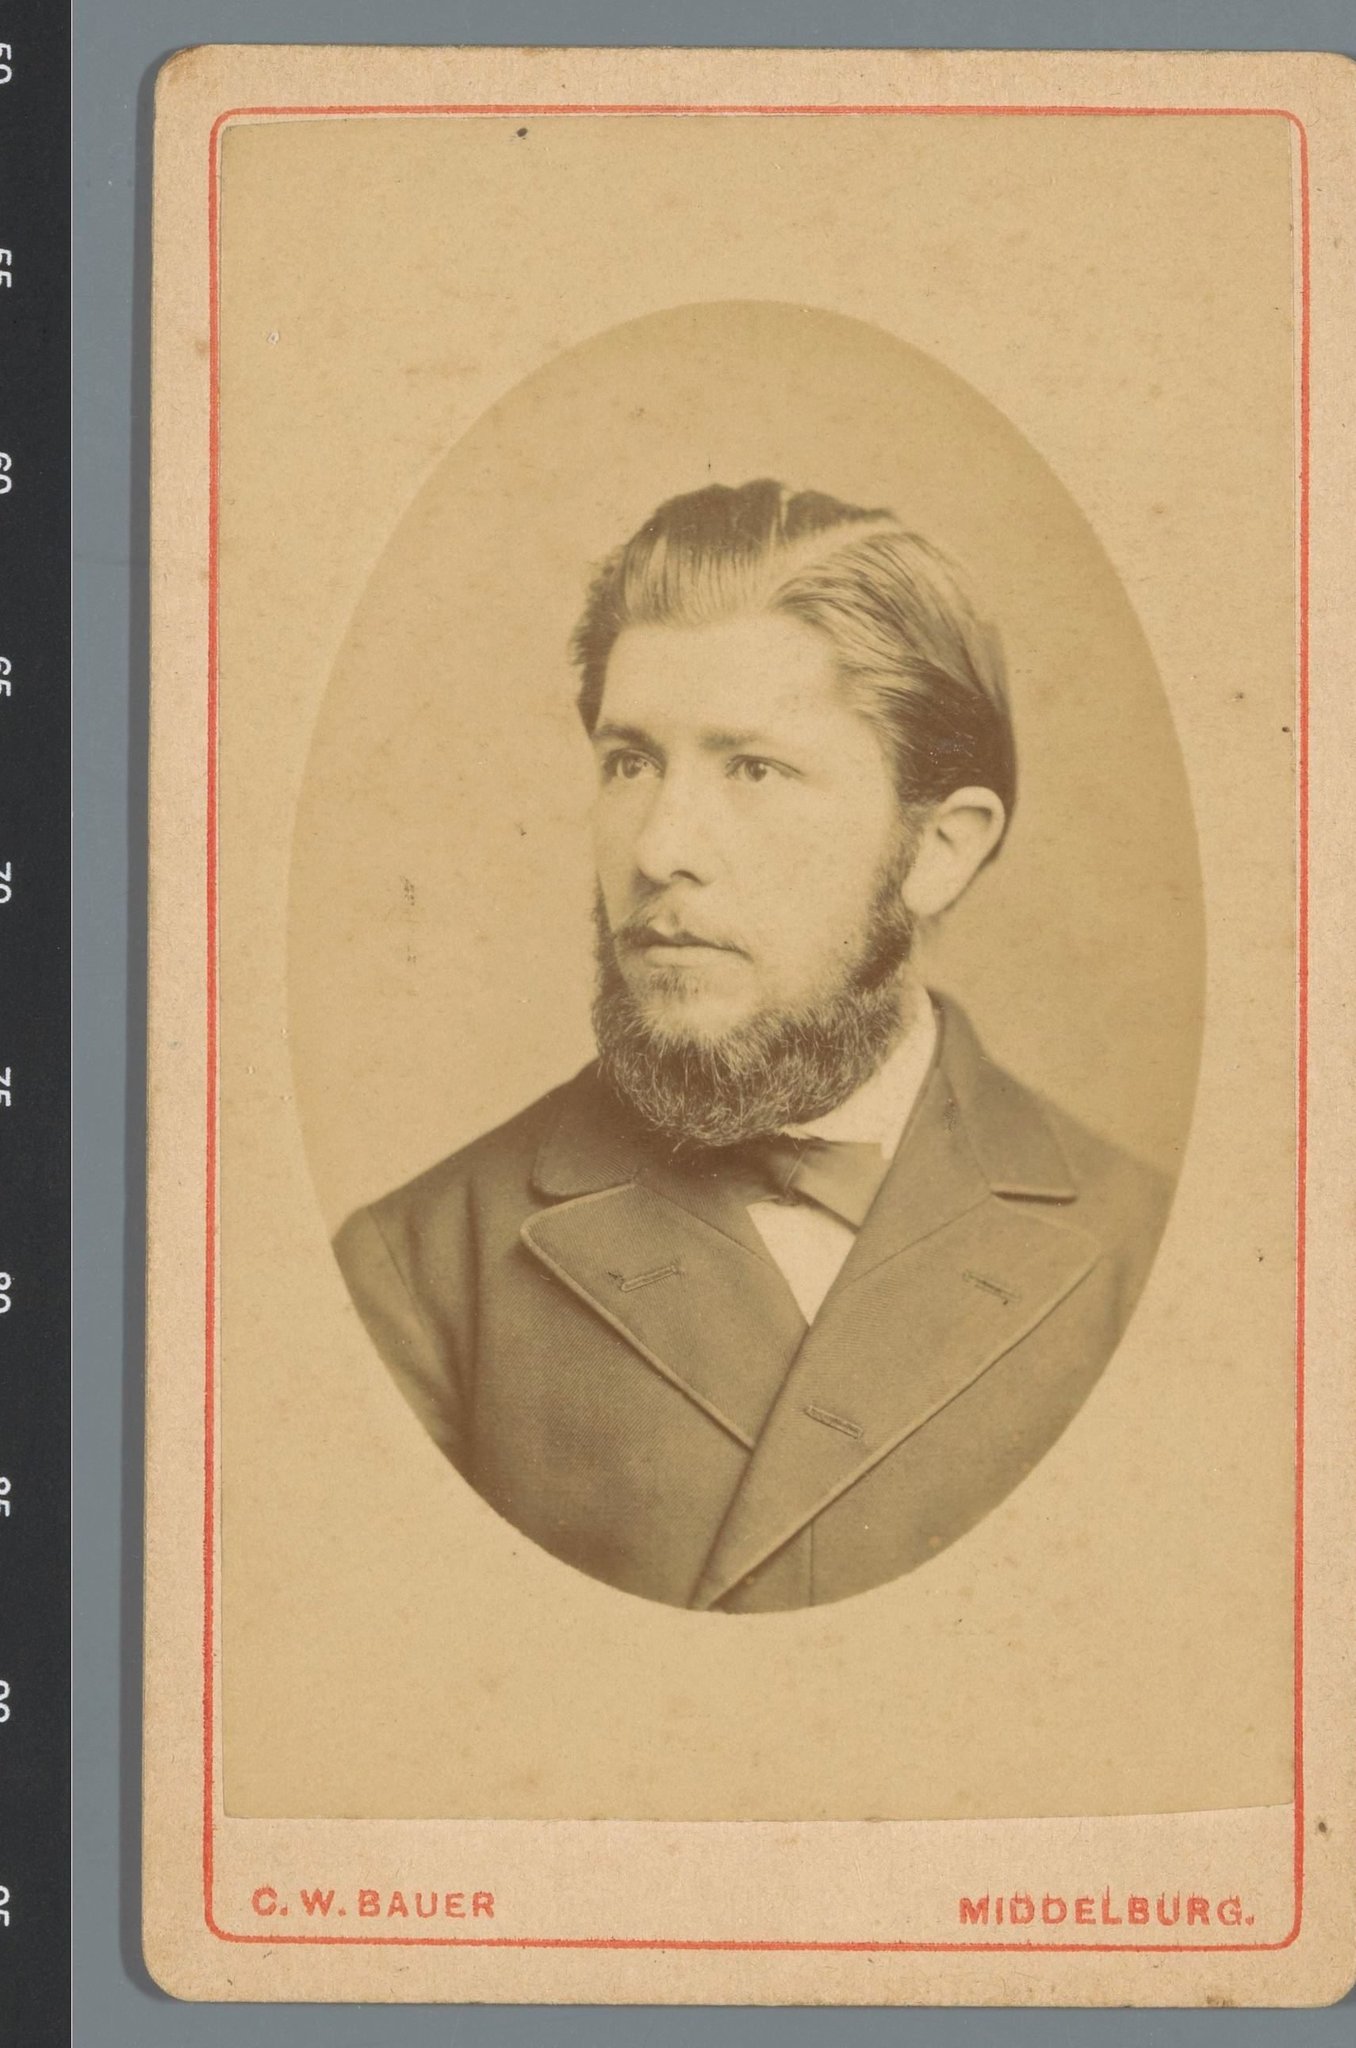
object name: carte de visite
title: Portret van een onbekende man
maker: carl wilhelm bauer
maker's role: fotograaf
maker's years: 1844-1911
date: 1881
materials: cardboard, paper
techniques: albumen print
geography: middelburg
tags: adult man, historical persons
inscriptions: inscription: ‘AMSTERDAM/ 1877/ C.W. BAUER/ PHOTOGRAPHE/ MIDDELBURG/ ATELIER voor Photographie/ Kool en Lichtdruk/ en/ Photolithographie.’, inscription: ‘1881’